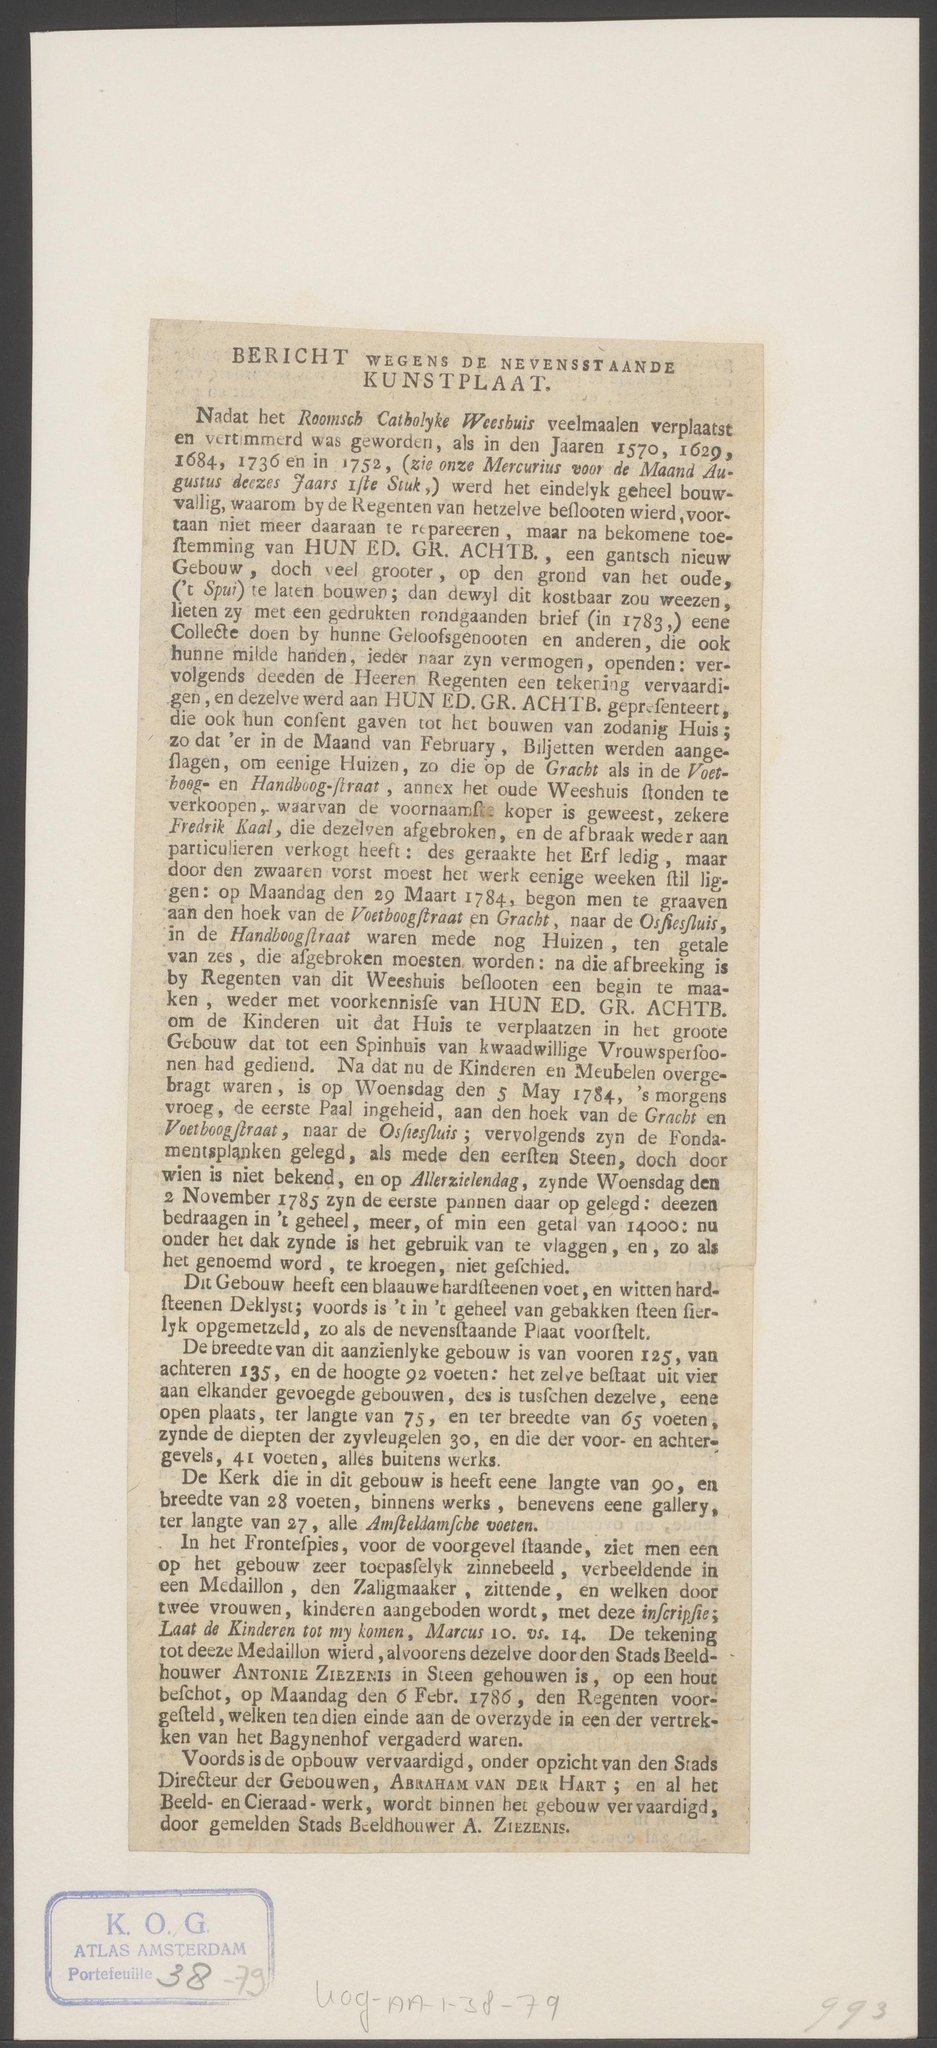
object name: text sheet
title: Verklarende tekst bij een prent van het Maagdenhuis te Amsterdam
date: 1710-1786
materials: paper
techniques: letterpress printing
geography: northern netherlands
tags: orphanage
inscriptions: collector's mark: Lugt 1641b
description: Object bestaat uit twee aan elkaar geplakte bladen. Onderwerpsrubriek binnen de Atlas Amsterdam: Armwezen en liefdadige instellingen: II. Kerkelijke inrichtingen: Roomsch-Katholijk Jongens Weeshuis a/d Lauriergracht.